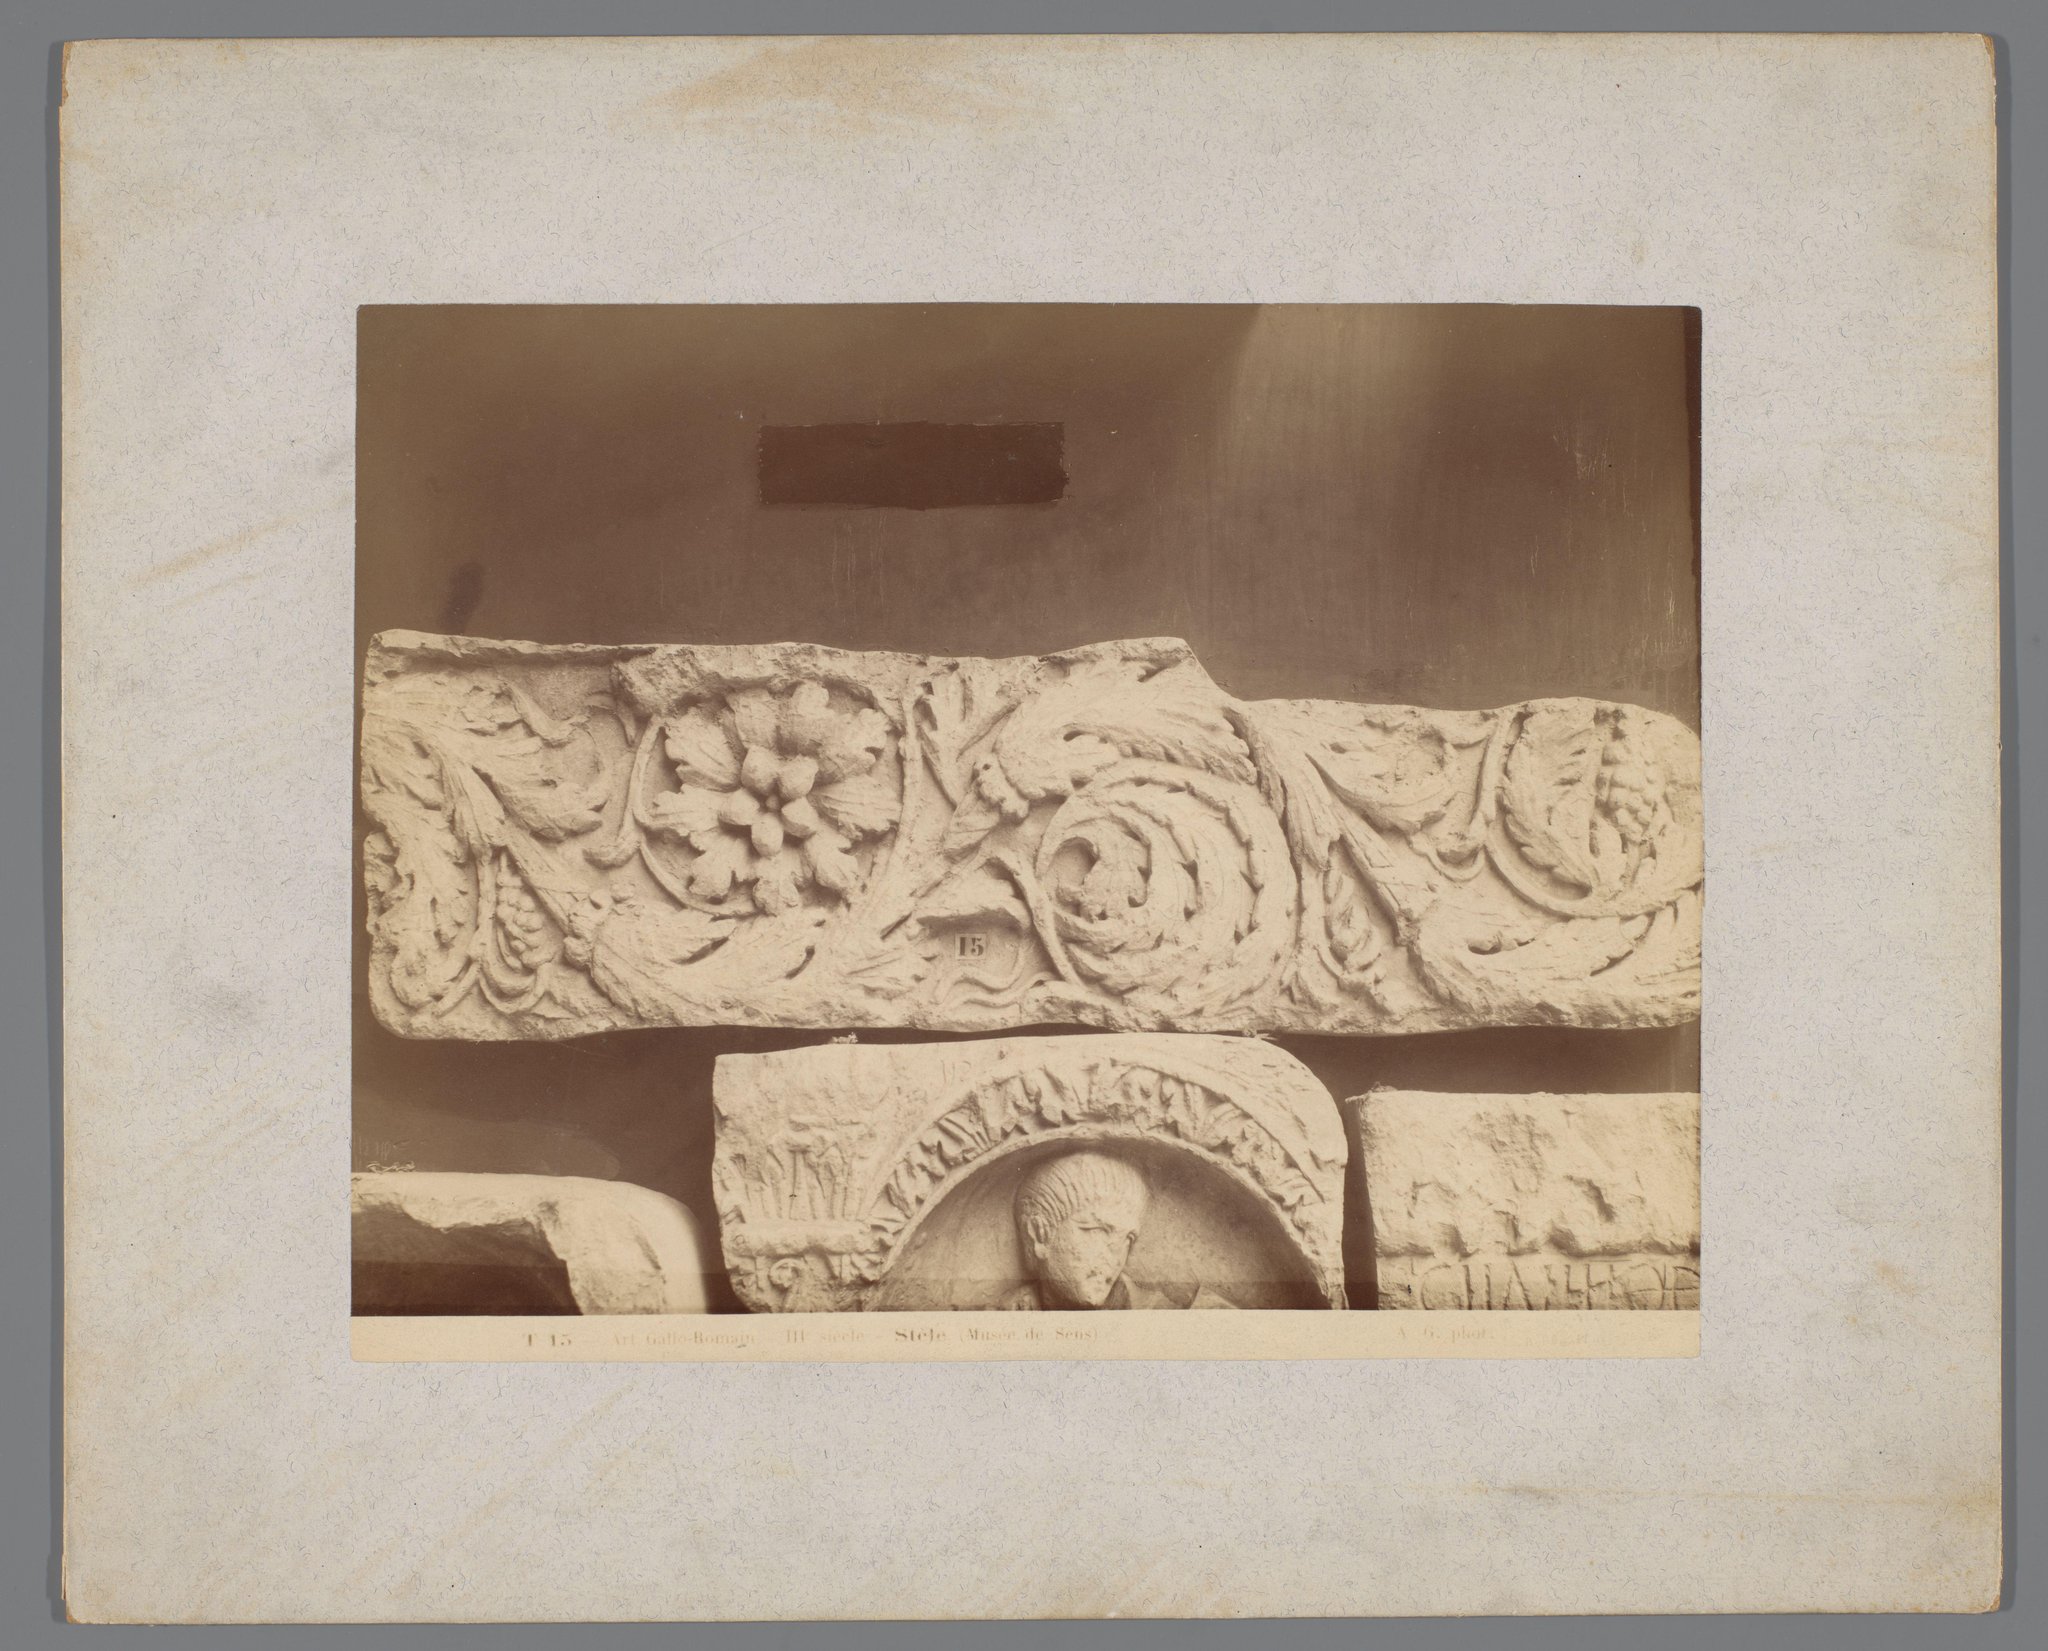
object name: photograph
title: Stèle in museum in Sens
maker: adolphe giraudon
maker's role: publisher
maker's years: 1849-1929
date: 1850-1900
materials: cardboard, photographic support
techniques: albumen print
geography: paris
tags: upright gravestone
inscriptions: collector's mark: ‘RIJKS-NORMAALSCHOOL voor TEEKENONDERWIJZERS. AMSTERDAM’, workshop stamp: ‘A. Giraudon/ Éditeur/ 15. R. Bonaparte. Paris’, number: ‘T 15’, inscription: ‘Musée de Sens’, inscription: ‘A.G. phot.’